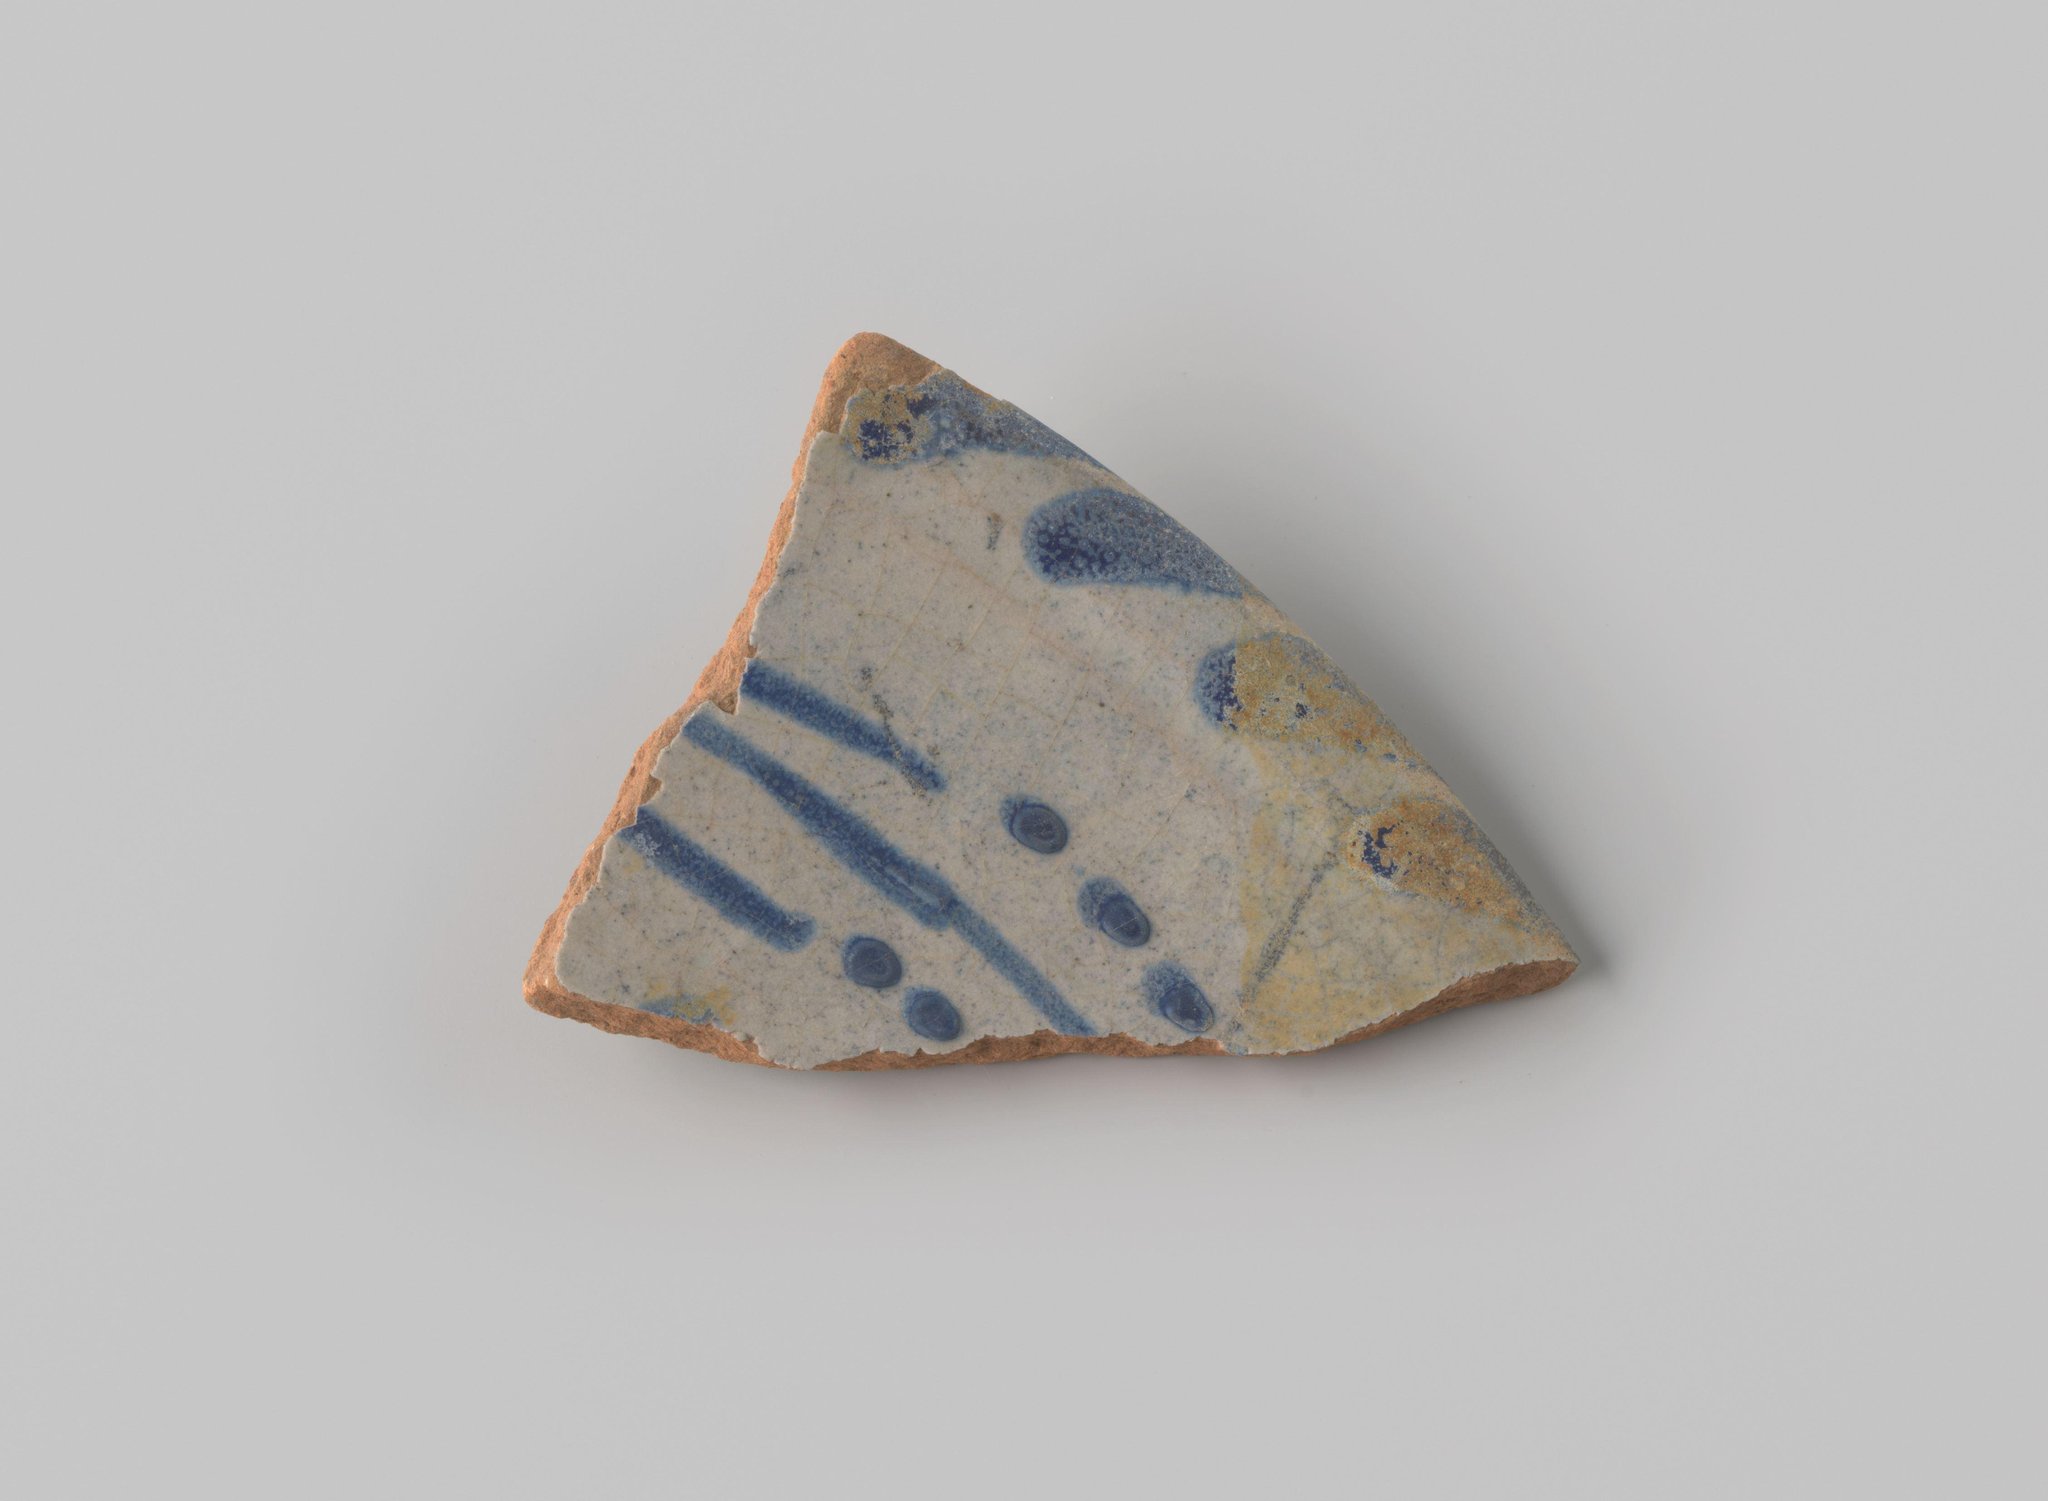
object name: sherd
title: Scherf van roodbakkend aardewerk, voorzien van wit glazuur, met aan de voorzijde strepen en stippen in blauw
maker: Anonymous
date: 1600-1650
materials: earthenware, glaze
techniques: maiolica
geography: northern netherlands